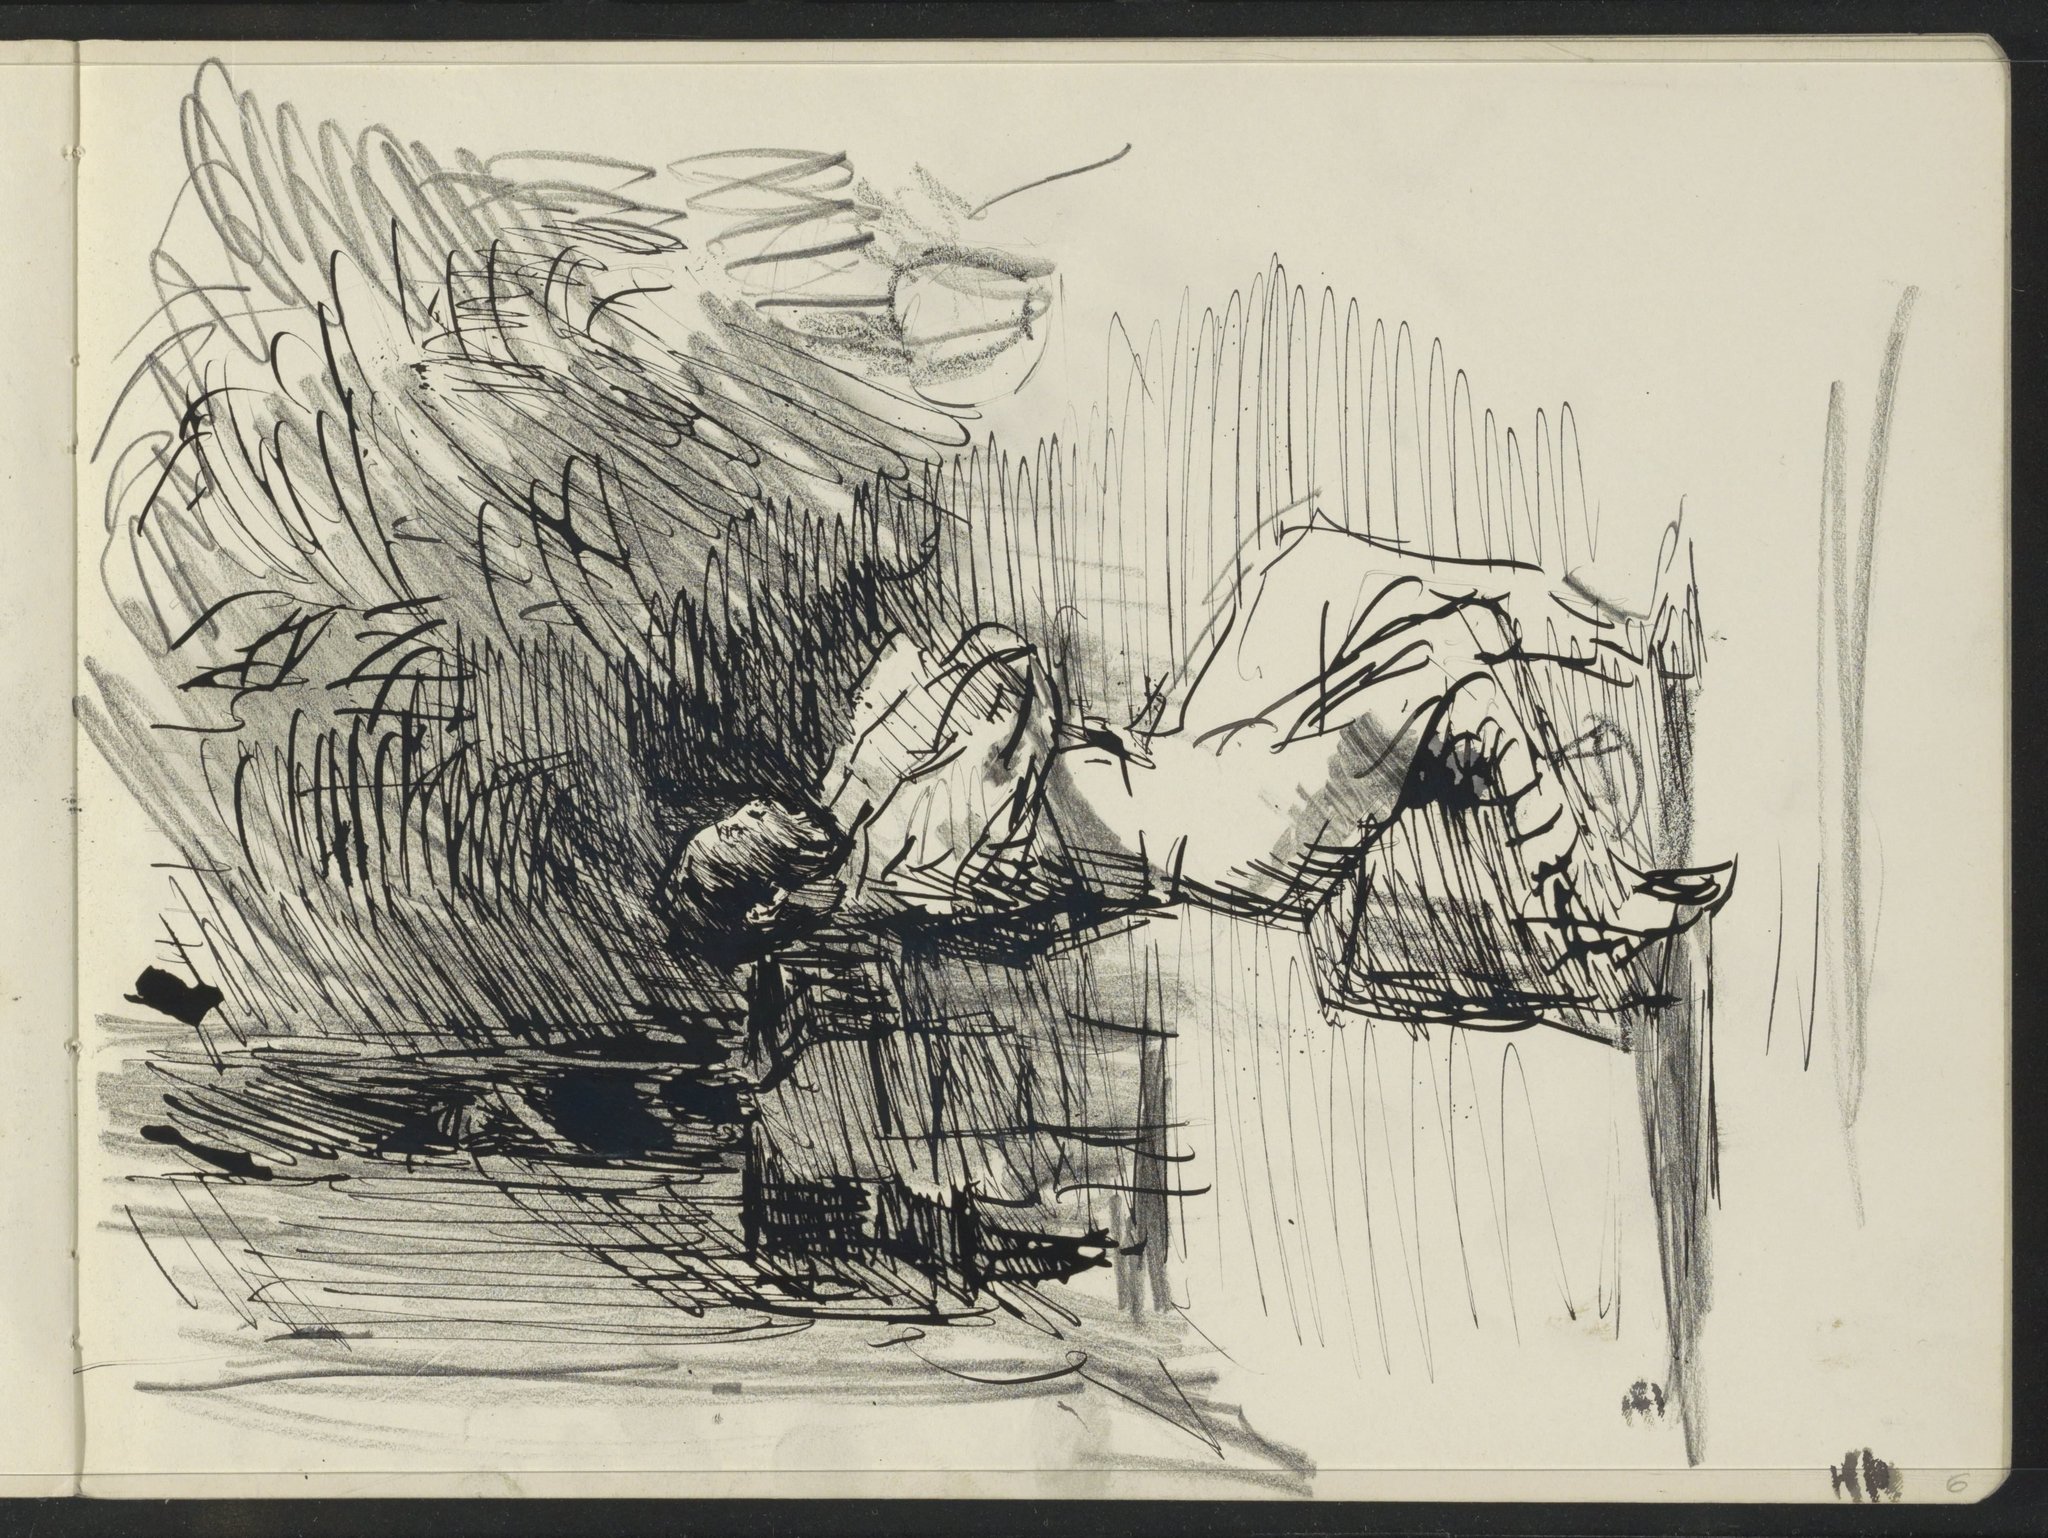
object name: sketchbook leaf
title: Zittende man, mogelijk op een podium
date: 1915-1934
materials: ink, paper, pencil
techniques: pen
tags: grand piano (+ artist at work), actor (on the stage), the stage and its equipment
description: Zijn armen houdt hij gekruist voor zijn borst. Op de achtergrond een man aan een piano. Blad 6 recto uit schetsboek XVI met 32 bladen.